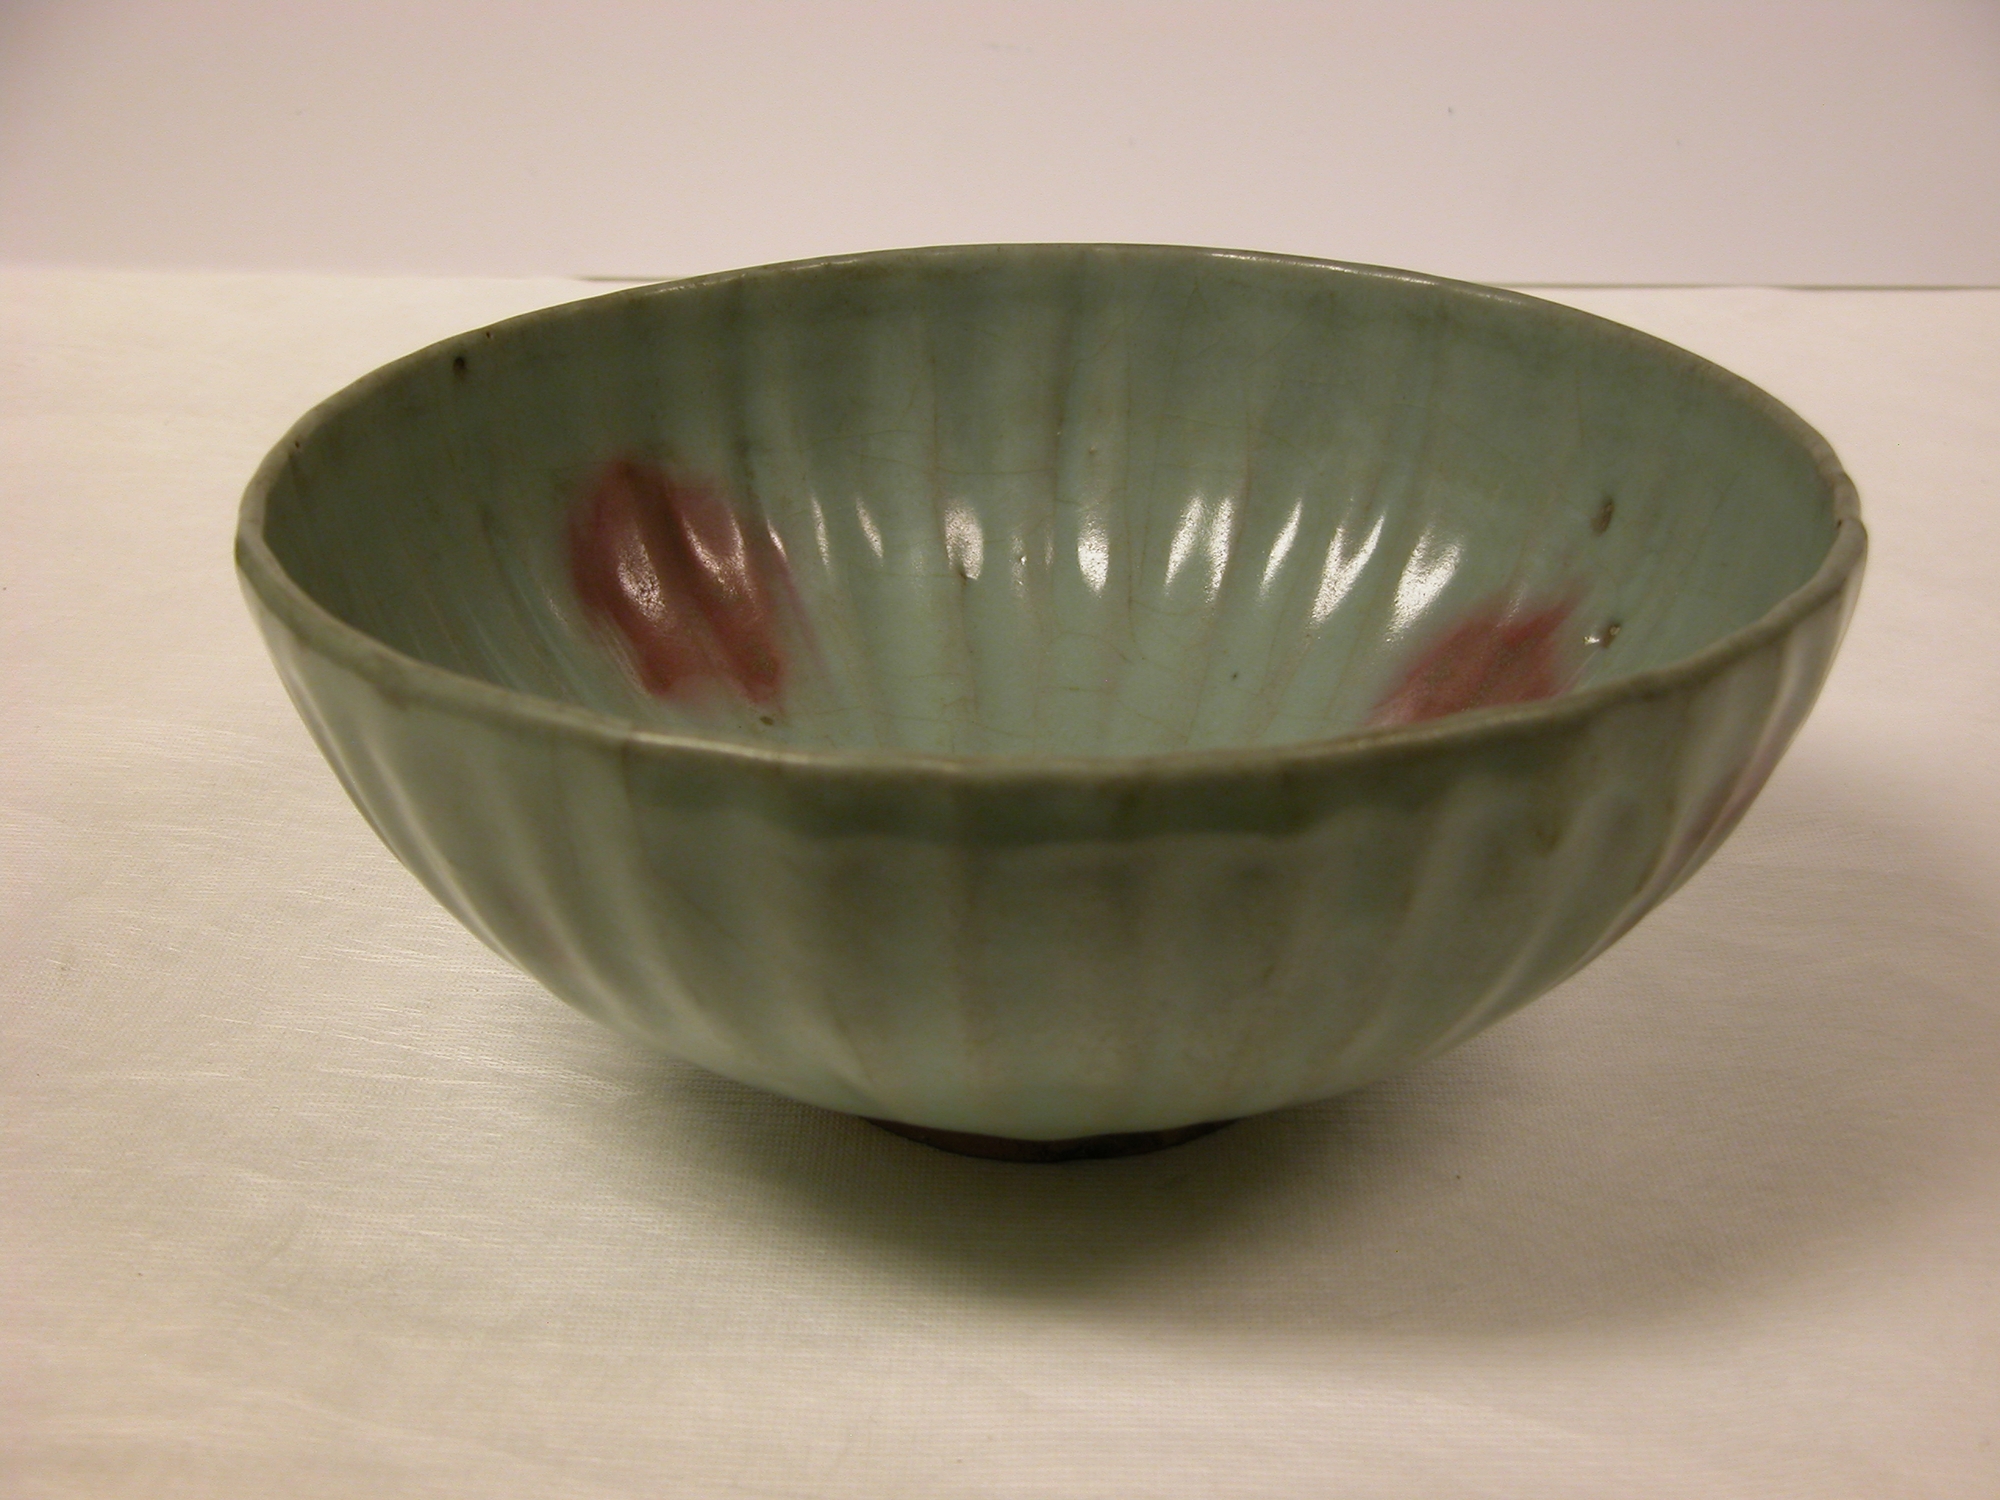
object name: bowl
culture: chinese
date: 960-1279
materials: pottery